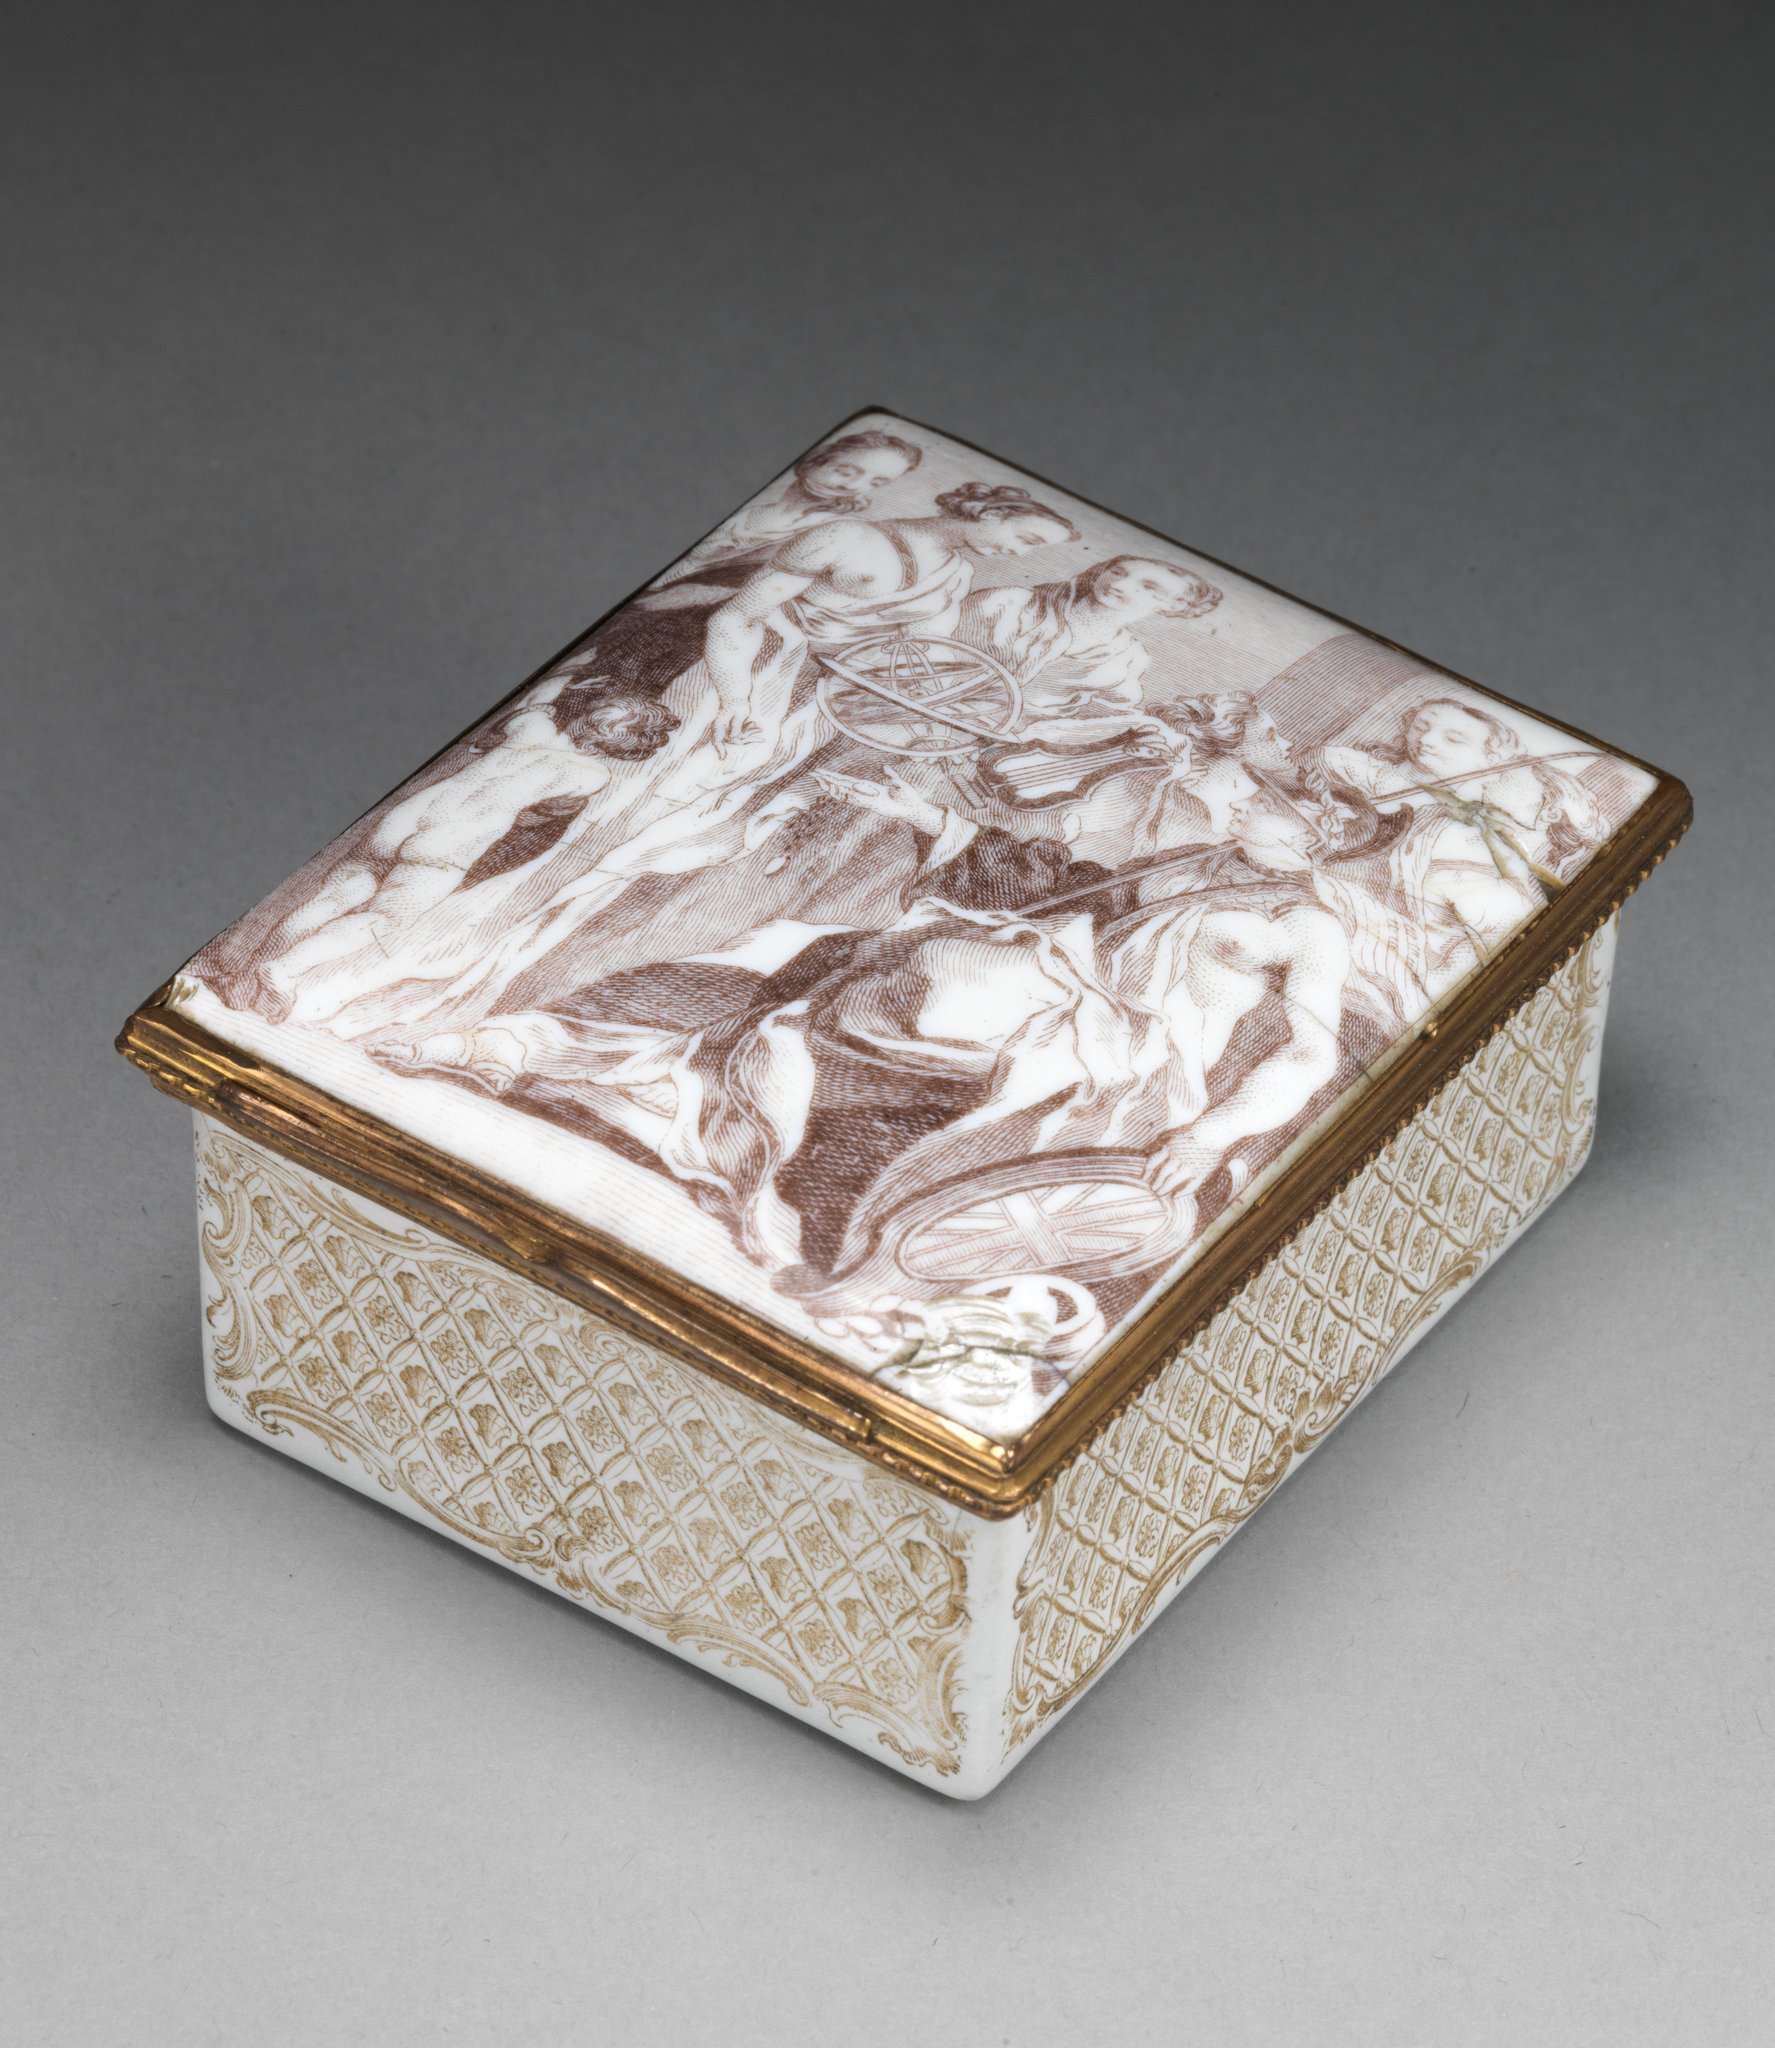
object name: snuffbox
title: Britannia giving coins to Science and the Arts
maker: simon francis ravenet, the elder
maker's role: artist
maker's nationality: french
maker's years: 1706-1774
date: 1753-1756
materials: copper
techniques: enamel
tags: men,women